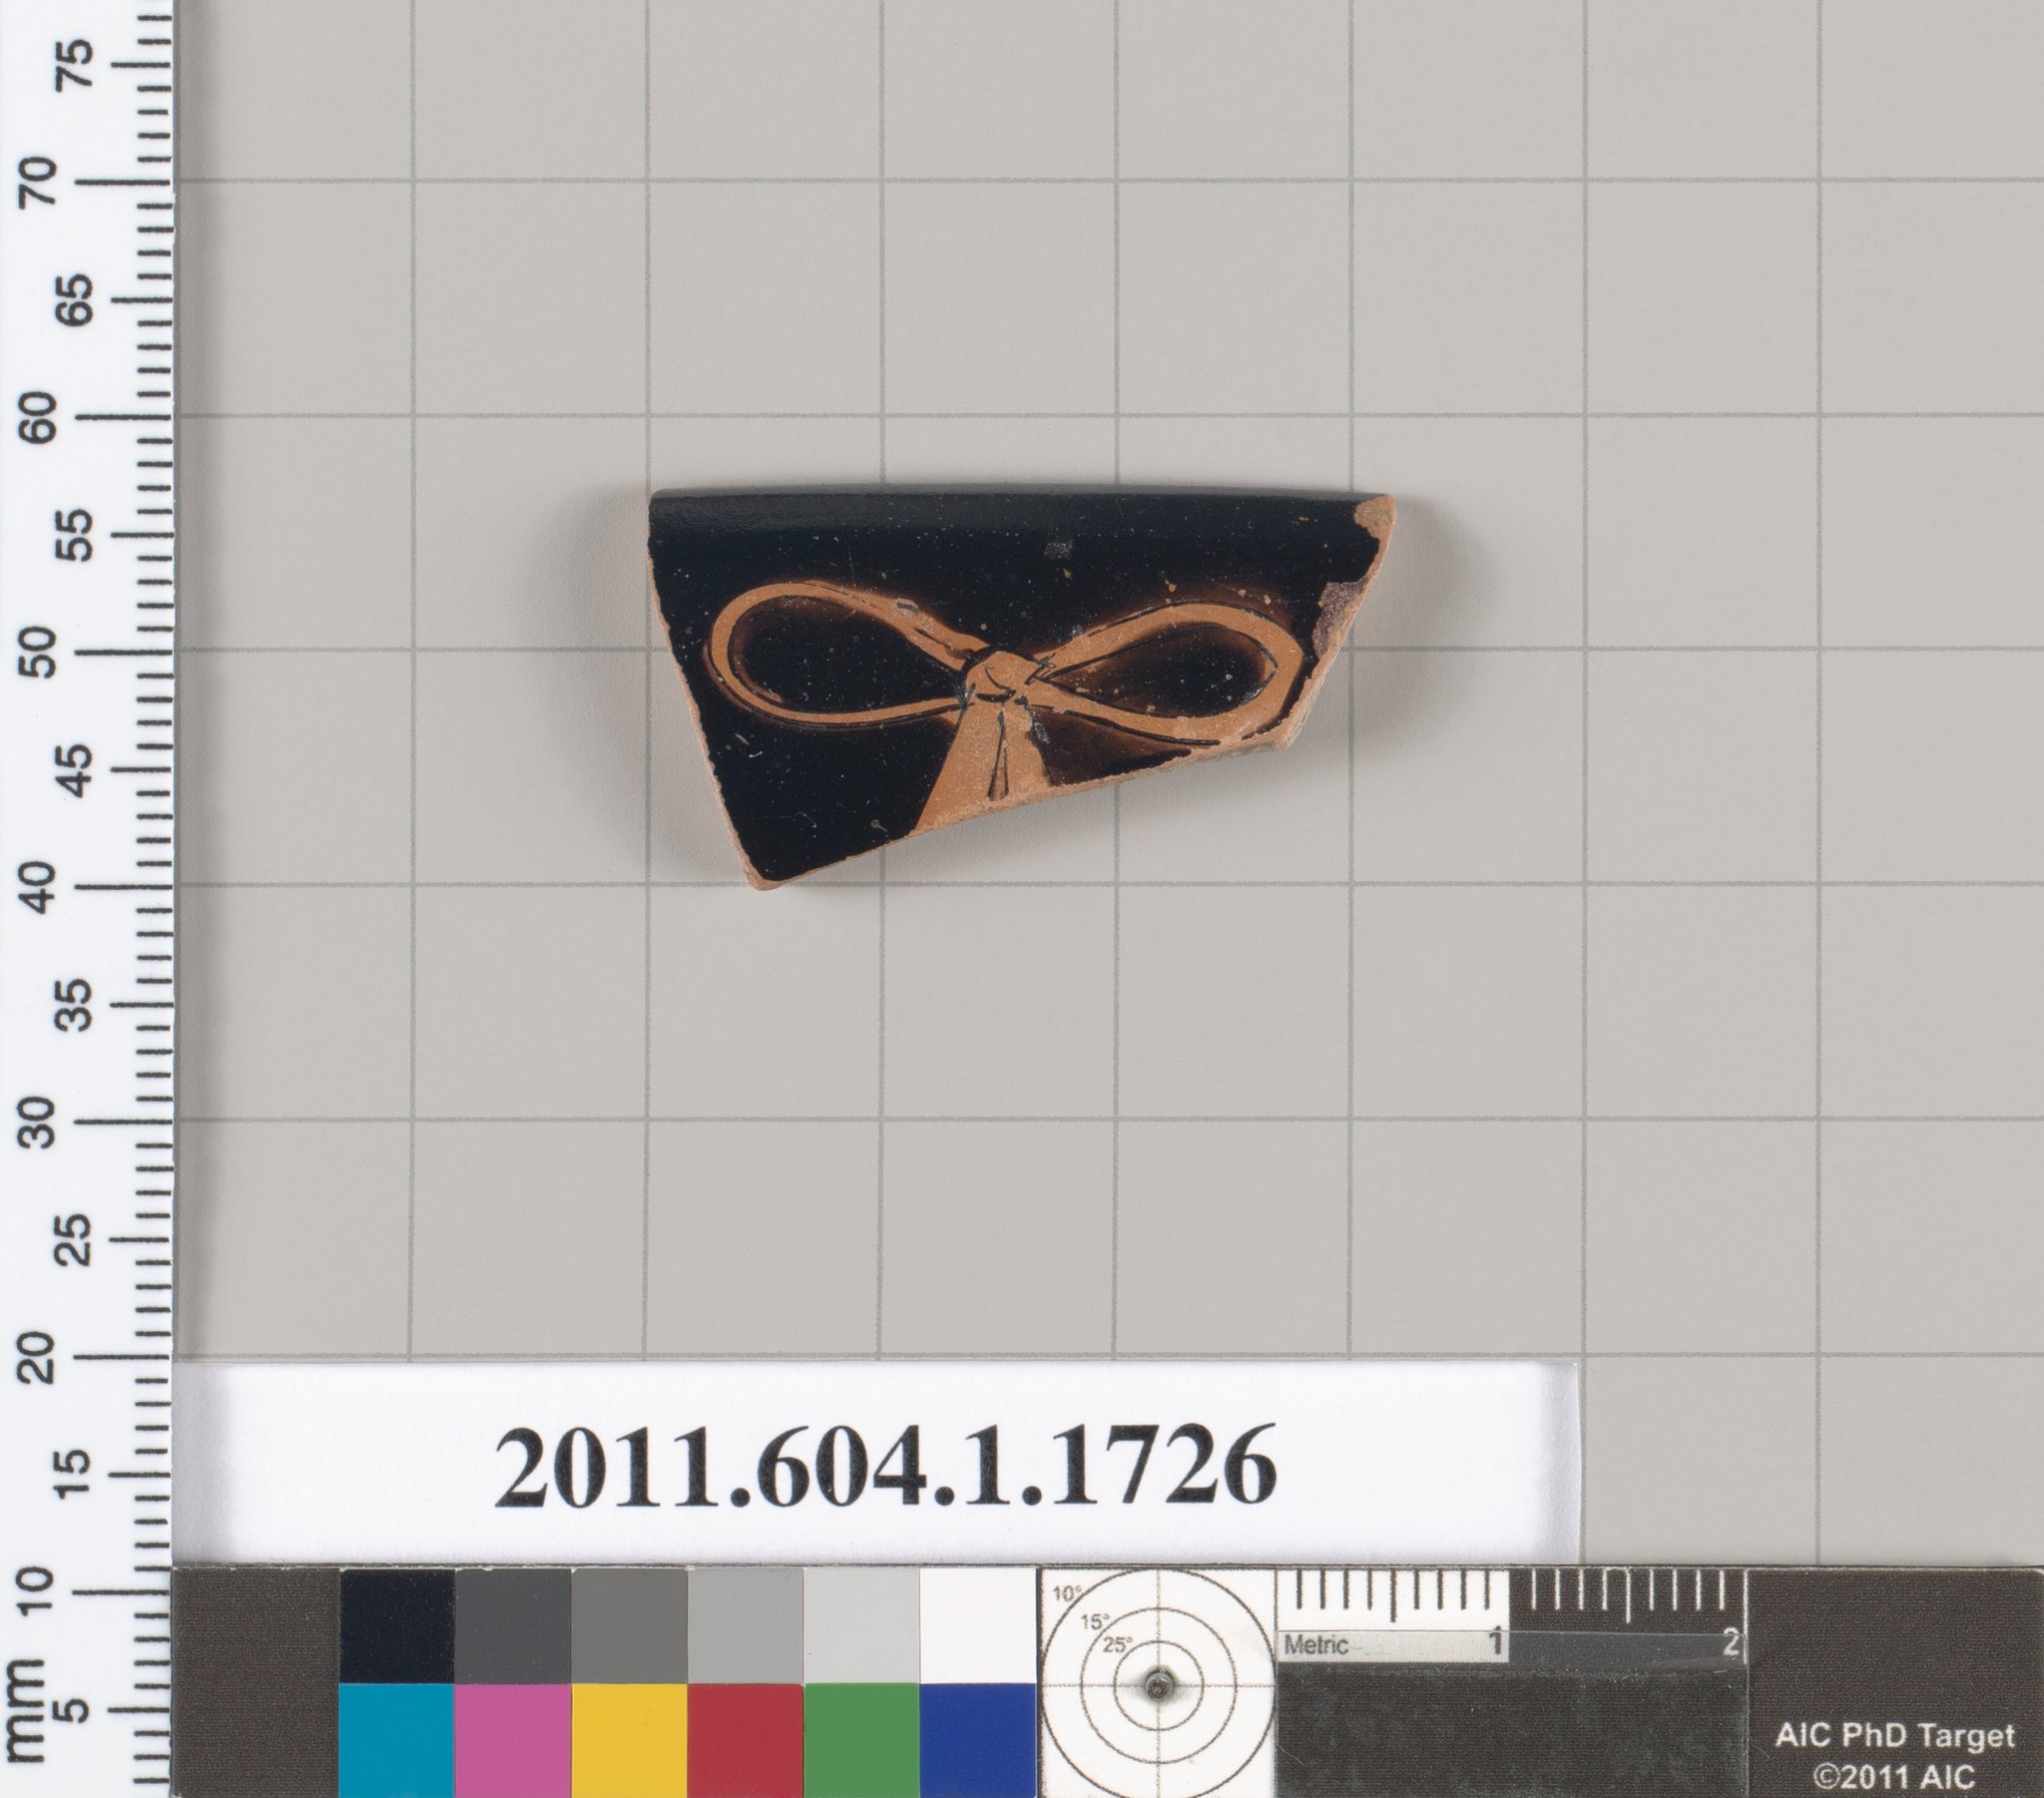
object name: kylix fragment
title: Terracotta rim fragment of a kylix (drinking cup)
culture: greek, attic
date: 490-480 BCE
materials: terracotta